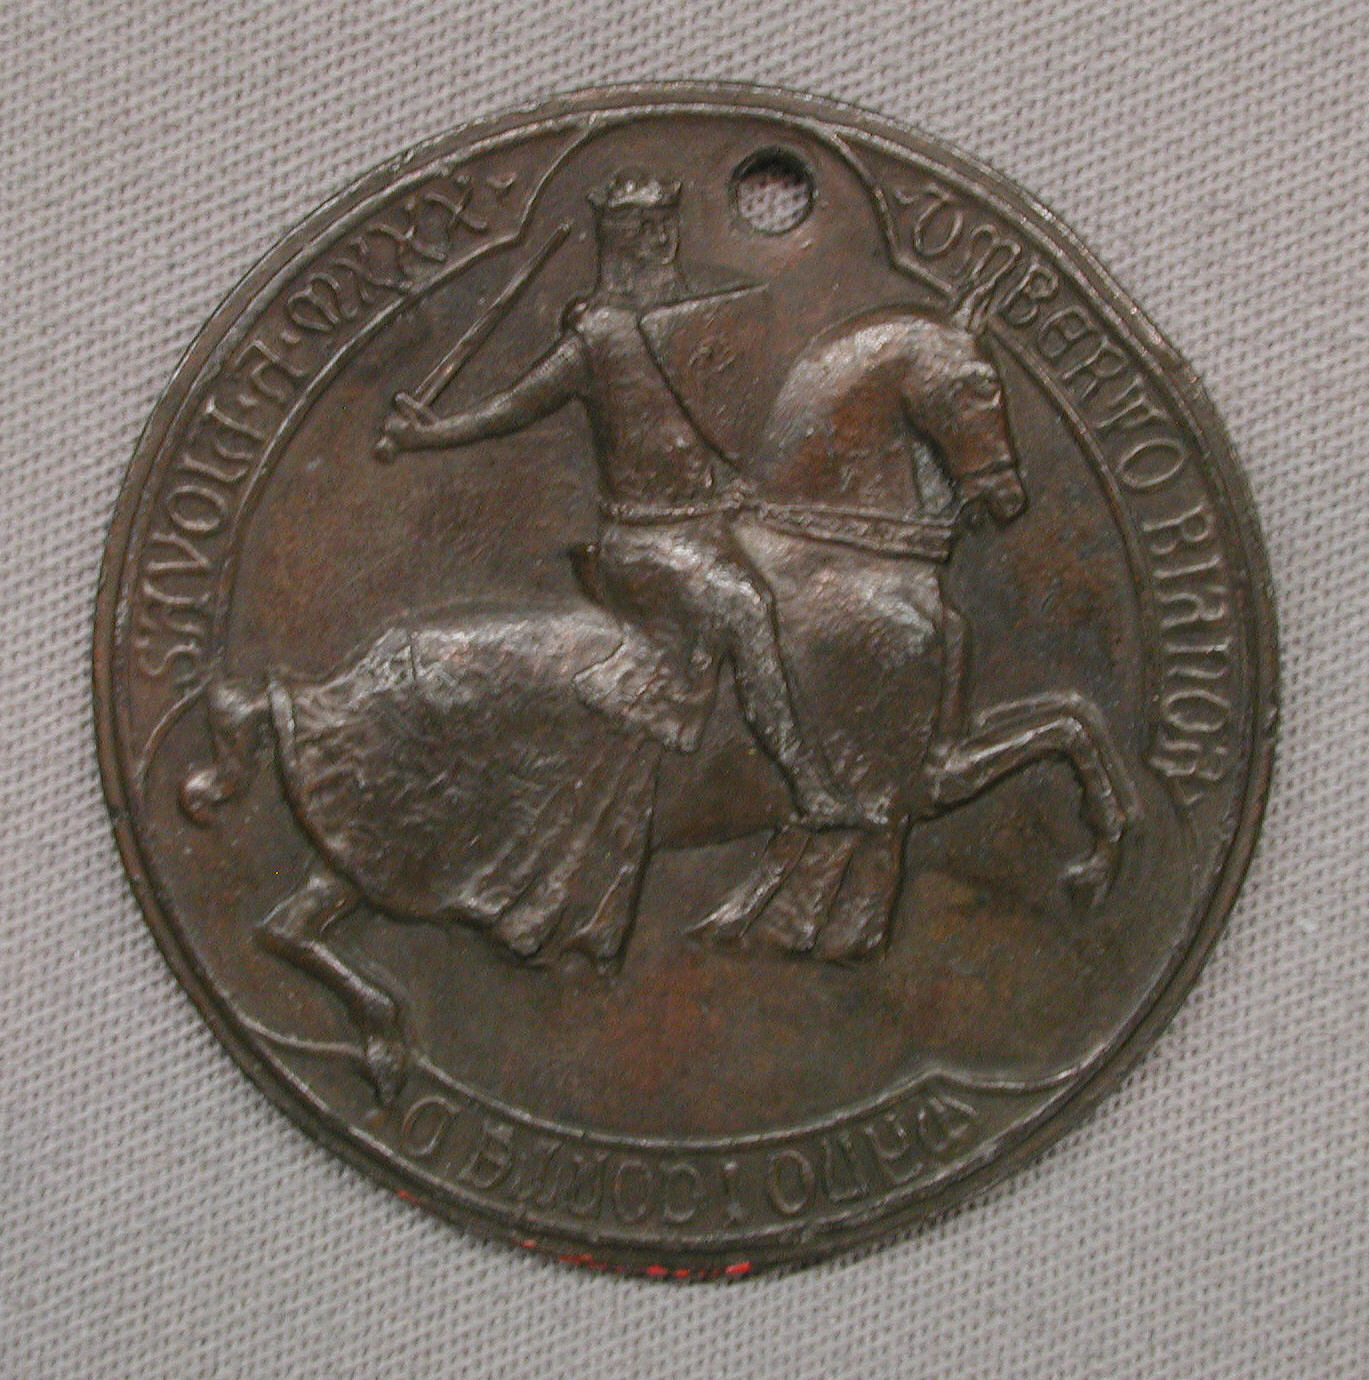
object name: medal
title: Umberto Biancomano of Savoy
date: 1893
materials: bronze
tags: human figures,swords,horses